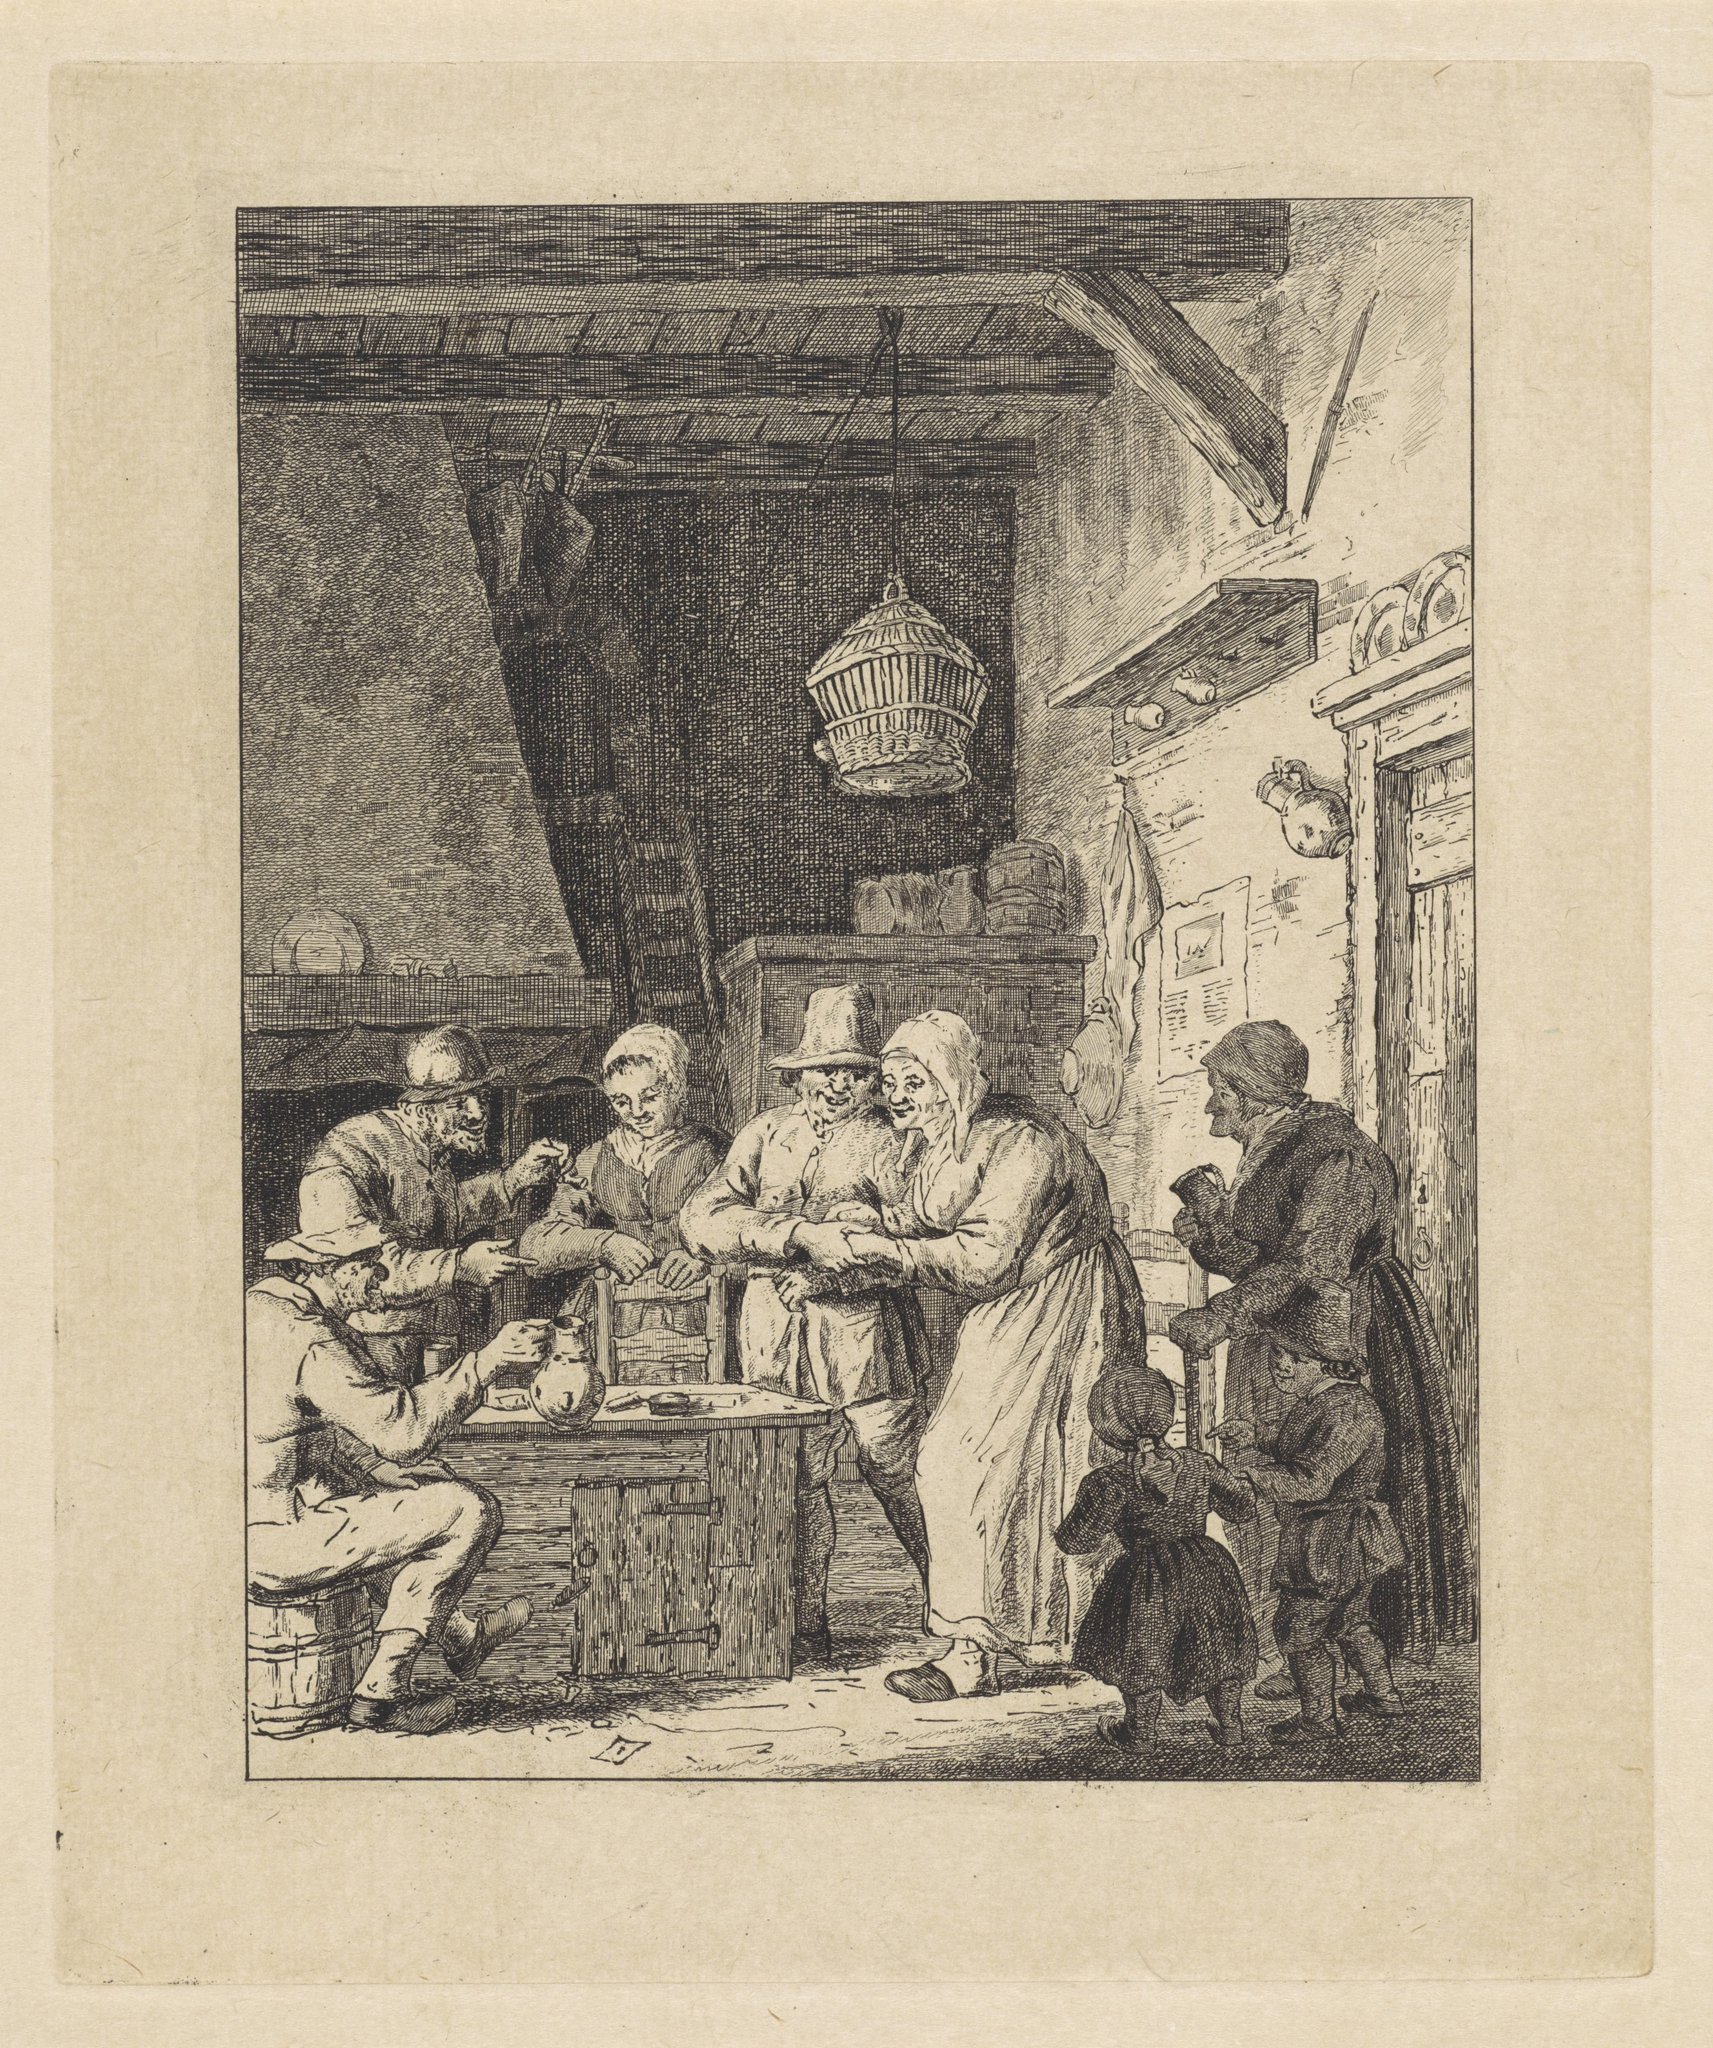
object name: print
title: Gezelschap in een interieur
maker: nicolaas van der worm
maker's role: draughtsman, print maker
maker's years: 1757-1828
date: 1772-1828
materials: paper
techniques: etching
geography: leiden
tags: family group, especially parents with their child(ren), communal rooms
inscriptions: collector's mark: Lugt 240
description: Een groep mensen van verschillende leeftijden heeft zich rond een tafel in een eenvoudig interieur verzameld. Enkelen van hen houden een kruik of een pijp vast.